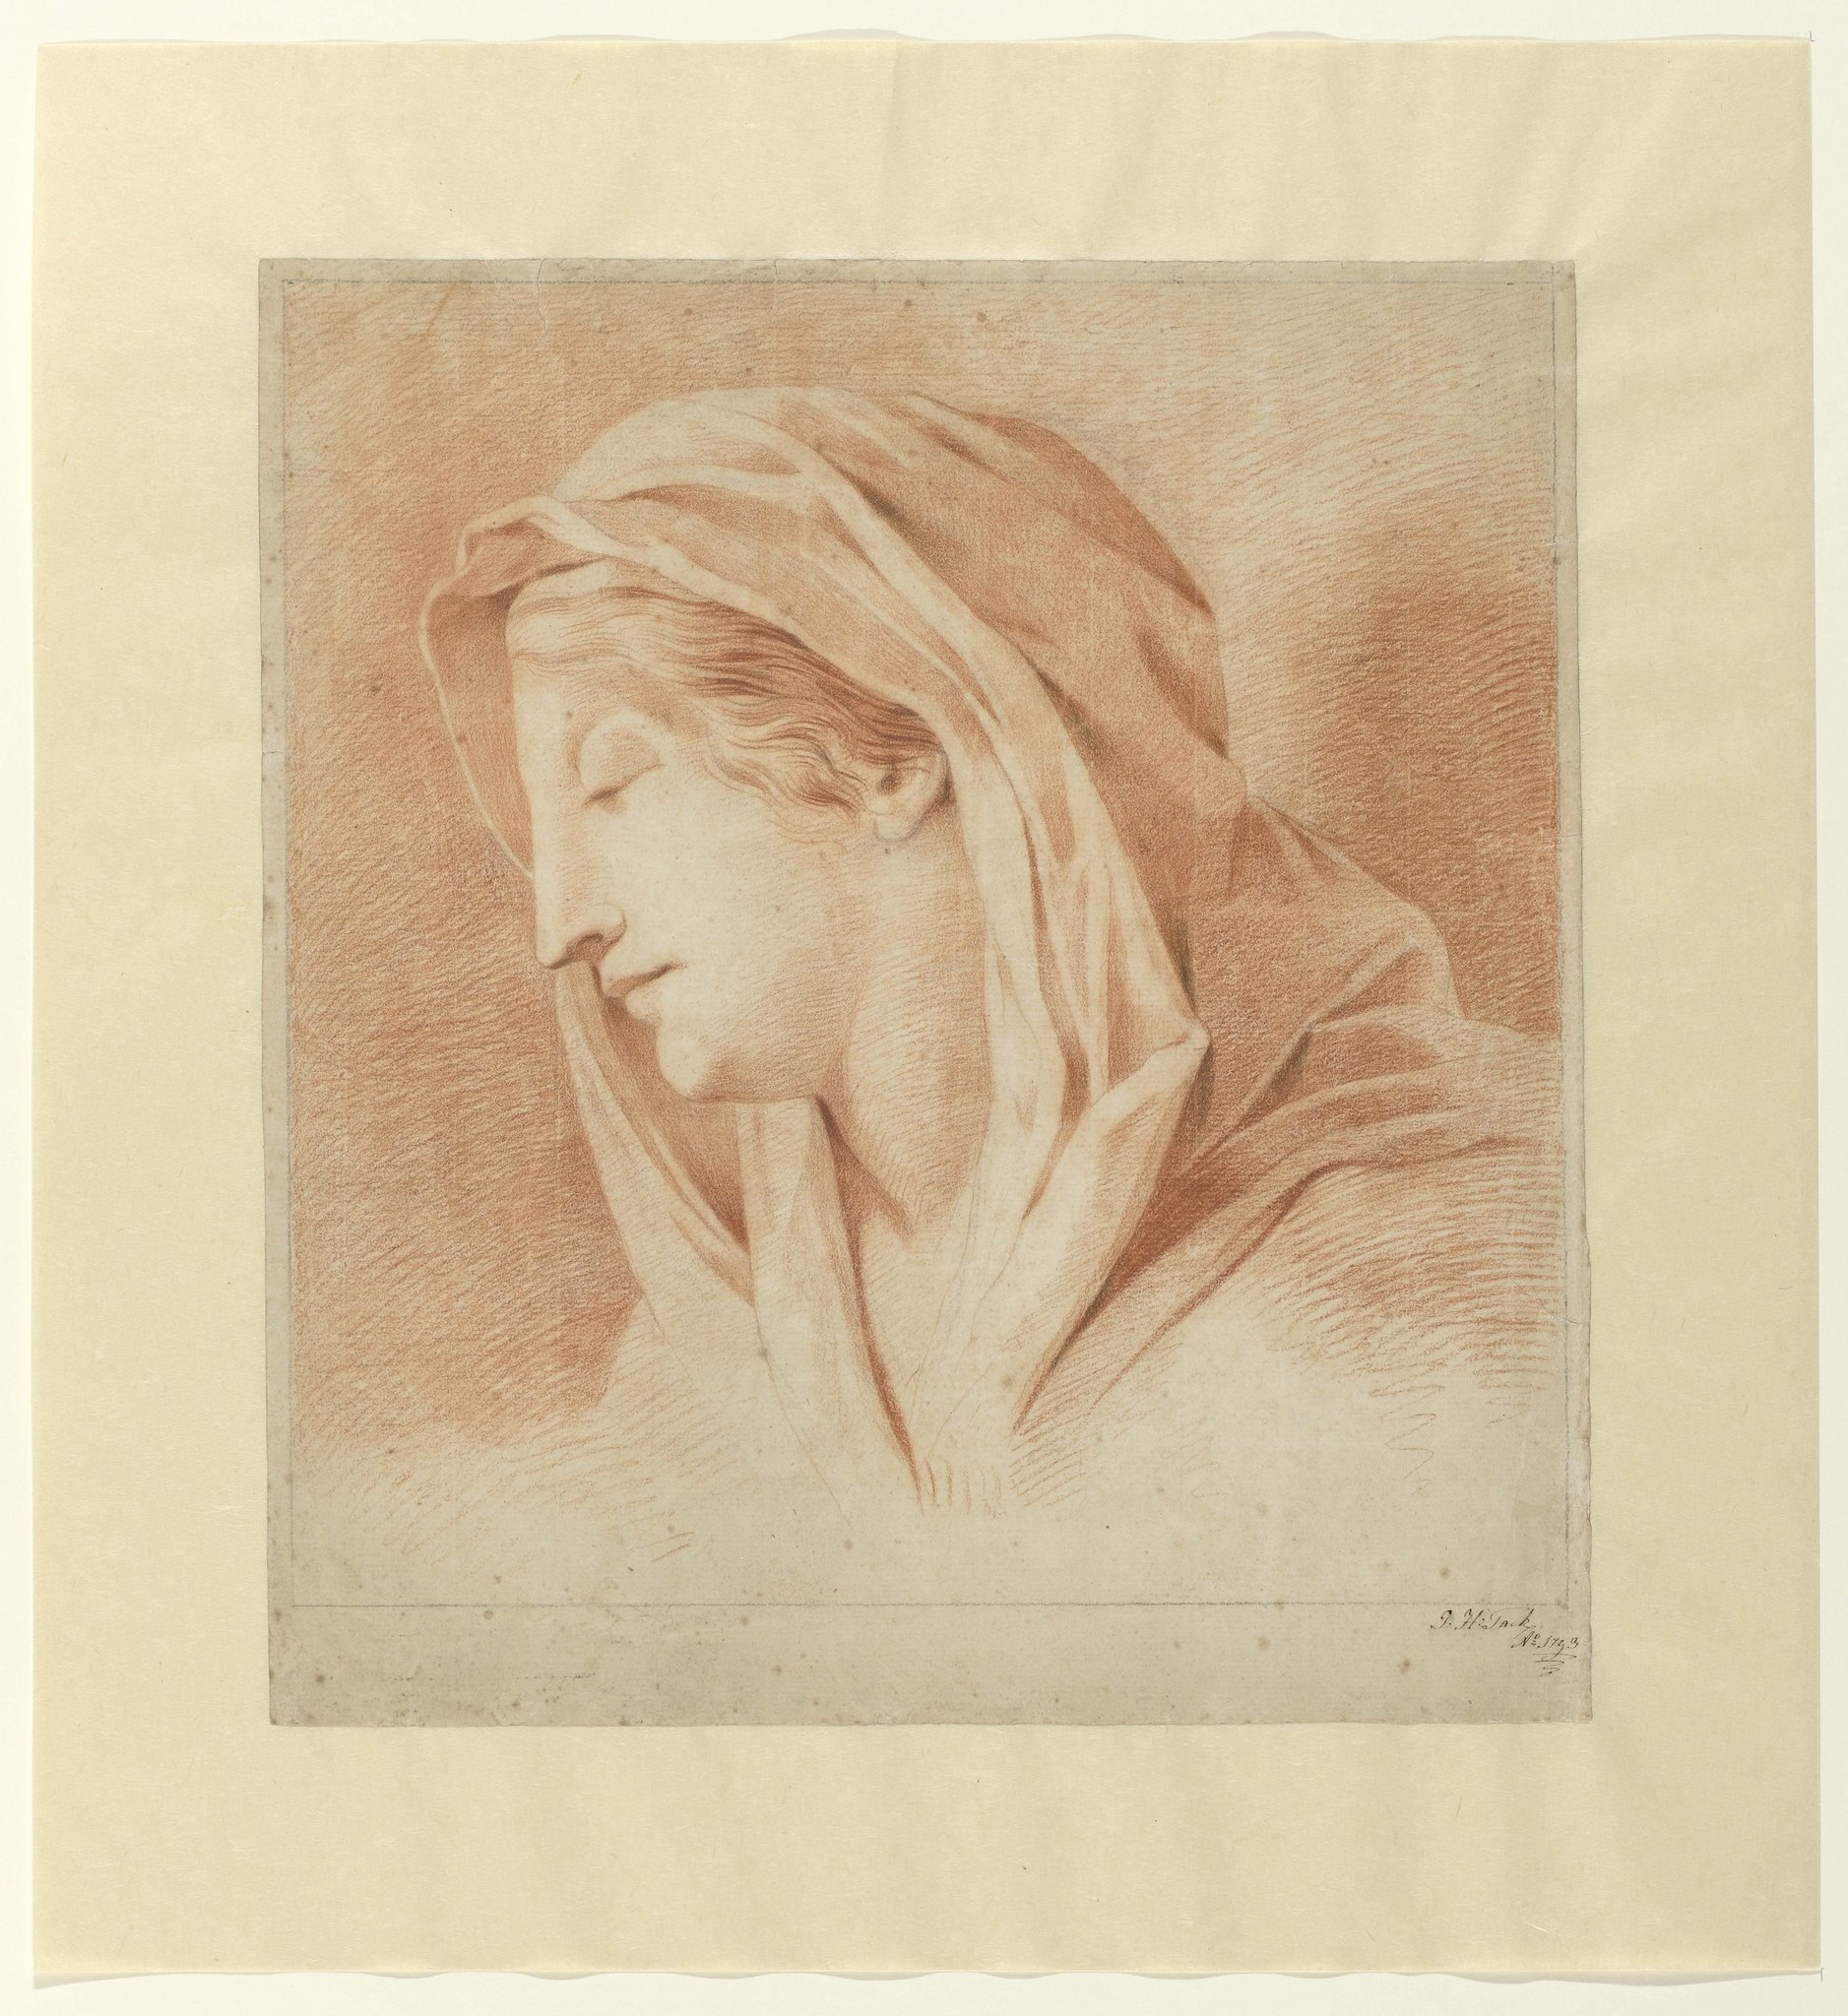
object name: drawing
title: Kop van een vrouw met hoofddoek, van opzij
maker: j.h. tak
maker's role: draughtsman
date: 1793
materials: chalk, paper